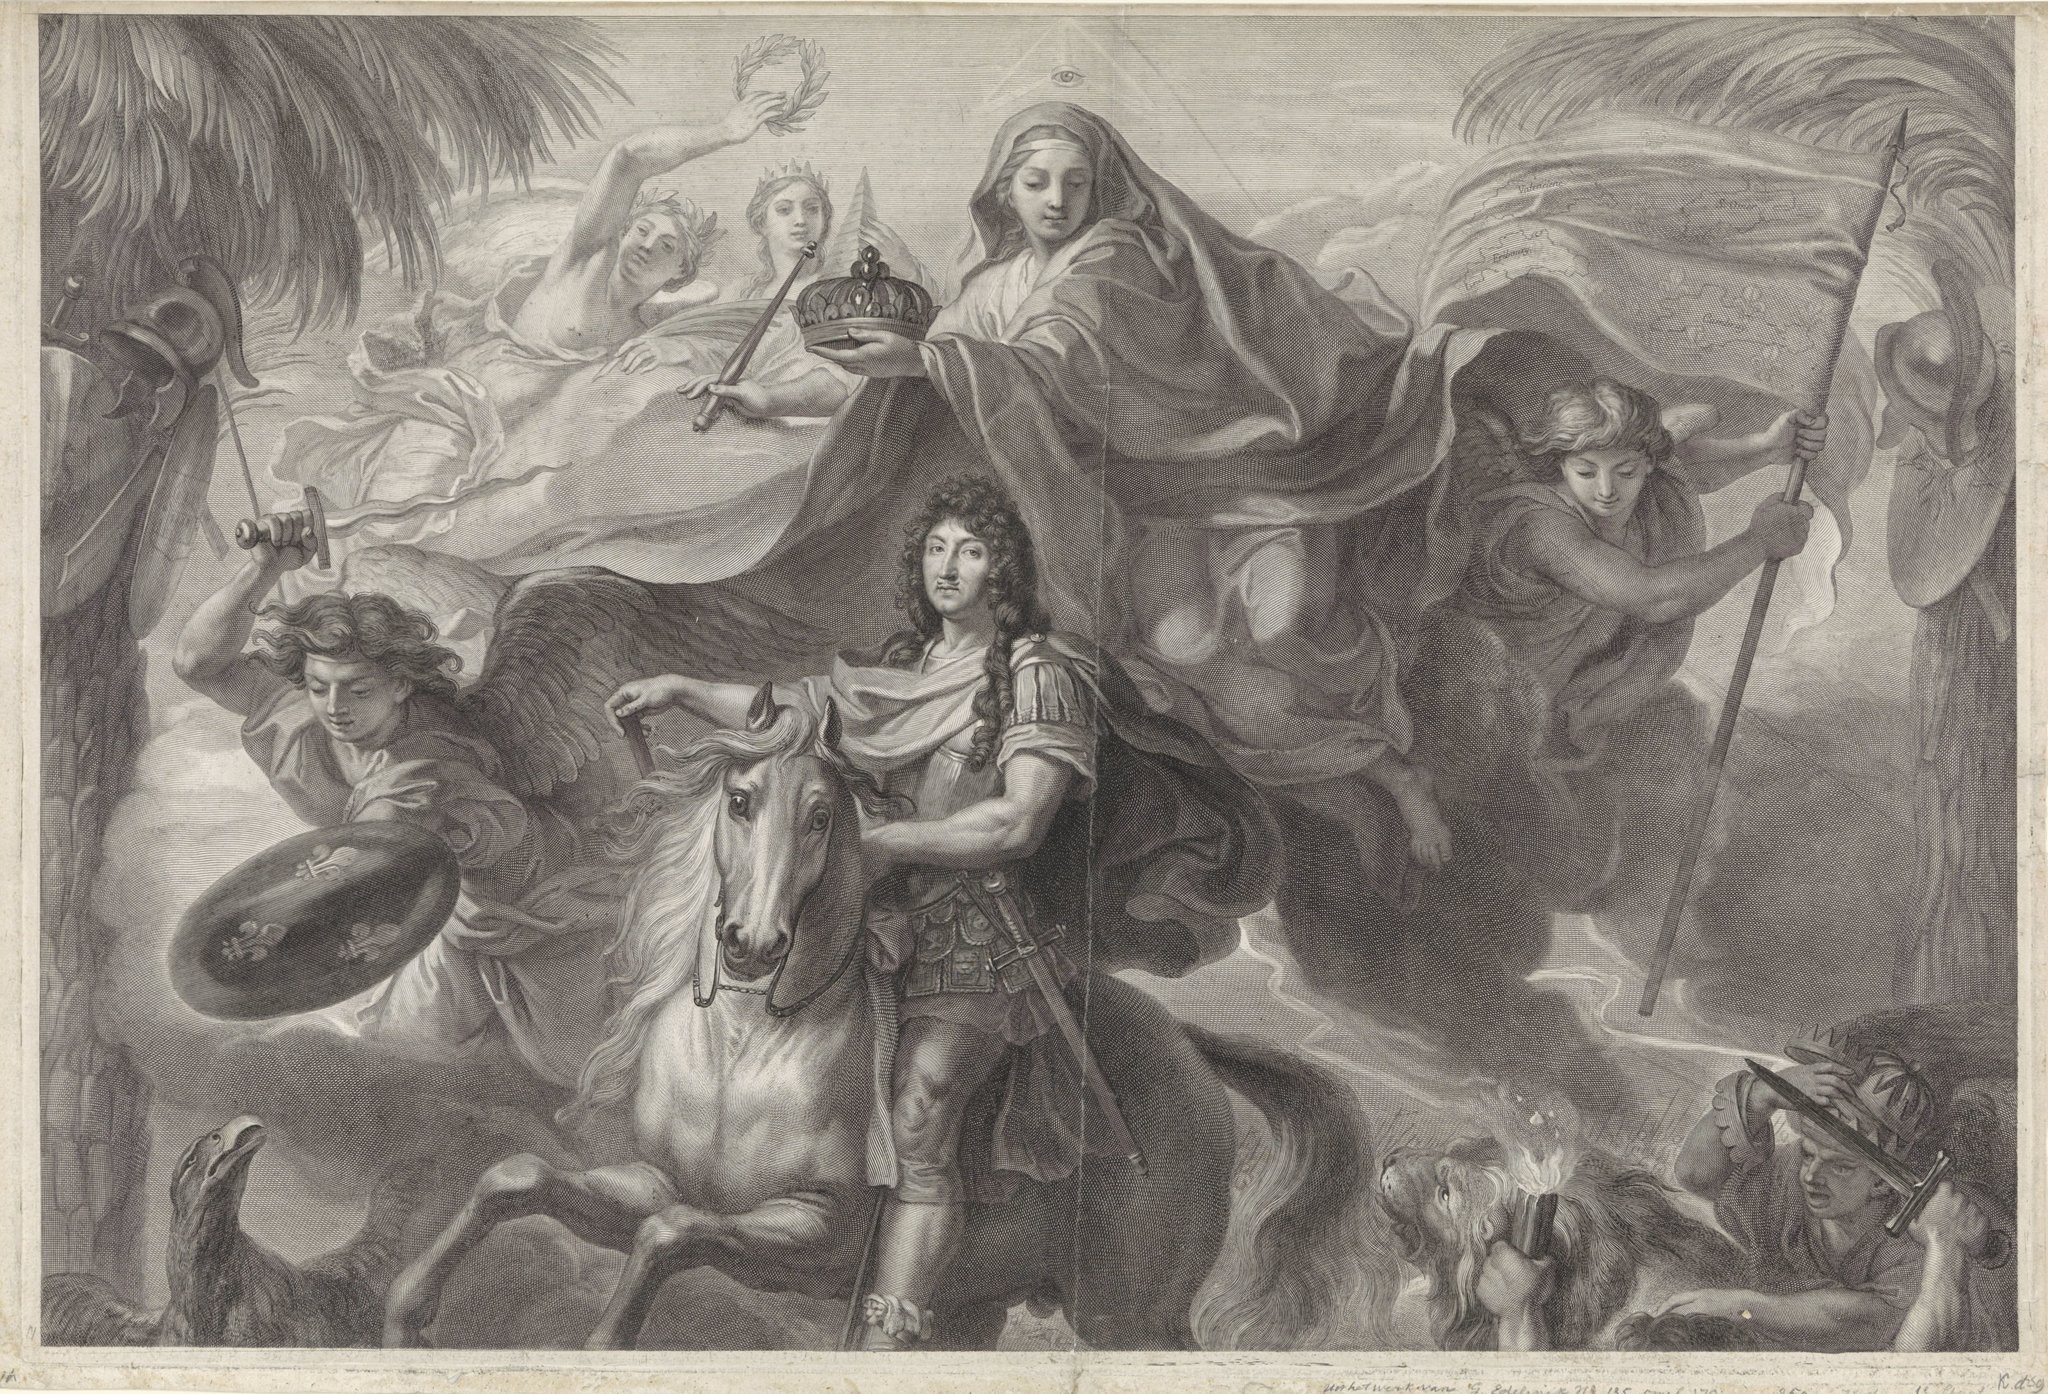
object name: print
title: Allegorisch ruiterportret van Lodewijk XIV, koning van Frankrijk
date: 1677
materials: paper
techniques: engraving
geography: france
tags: lodewijk xiv (koning van frankrijk)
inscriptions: collector's mark: Lugt 240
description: Bovenste deel van een prent met een allegorie op de zege van koning Lodewijk XIV. De heilige drieëenheid houdt de Franse kroon boven het hoofd van koning Lodewijk XIV te paard. Naast haar twee engelen waarvan één een vlag met door Frankrijk veroverde gebieden vasthoudt.